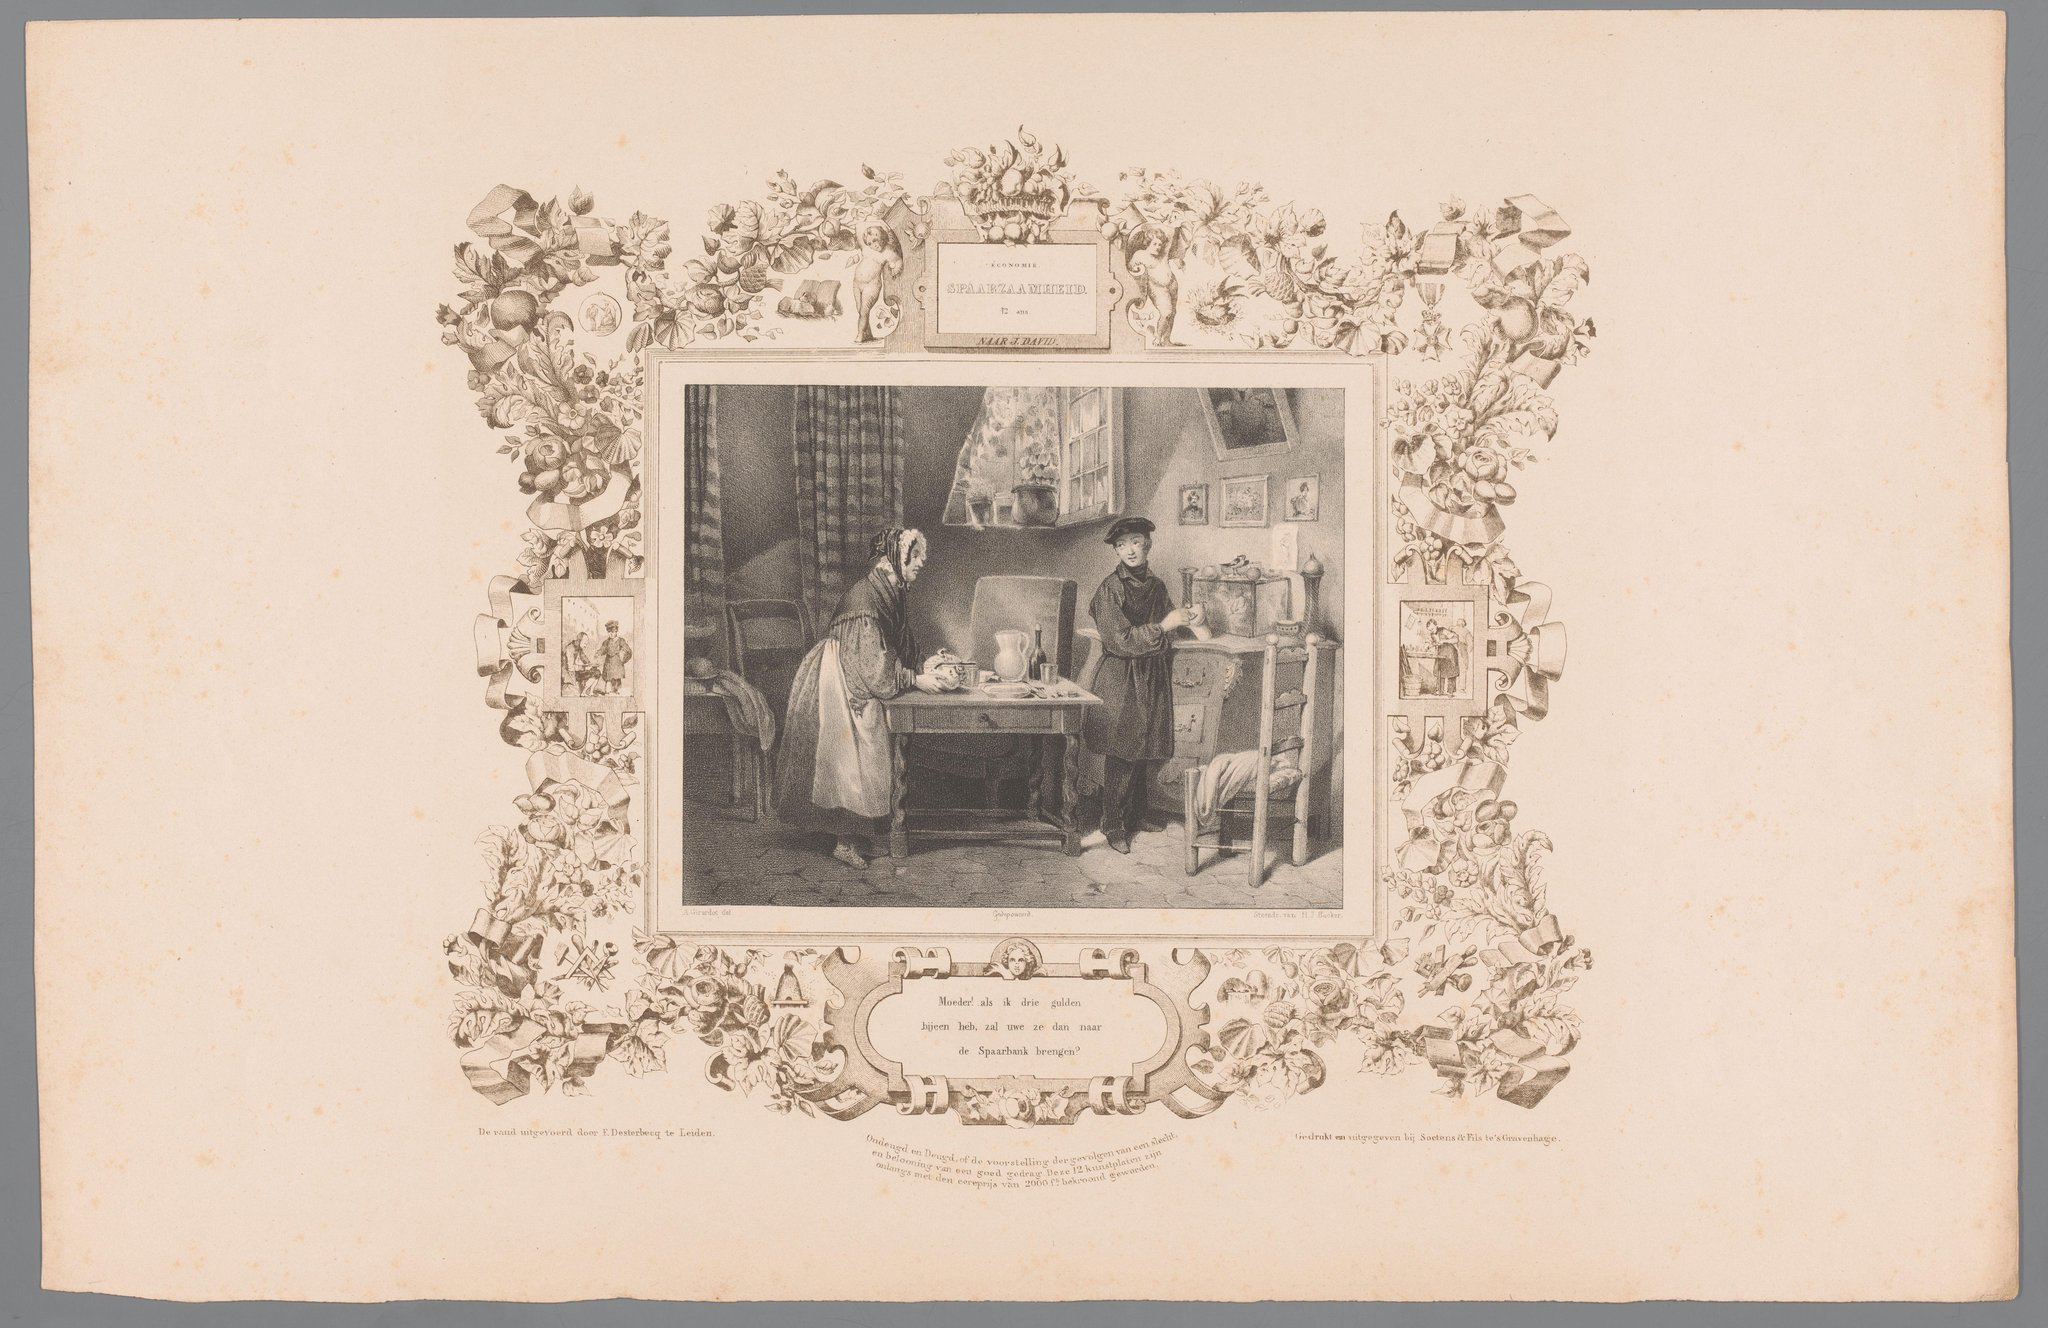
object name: print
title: Interieur met vrouw bij een tafel en een jongen die geld in zijn spaarpot stopt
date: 1837-1840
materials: paper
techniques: lithograph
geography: the hague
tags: saving, frugality, parsimony; 'parsimonia' (ripa), interior of the house, mother and child(ren), woman and child(ren) (family group)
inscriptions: collector's mark: Lugt 2228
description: In de rand symbolen die verwijzen naar deugd zoals het geven van een aalmoes, noeste arbeid en een ridderorde.